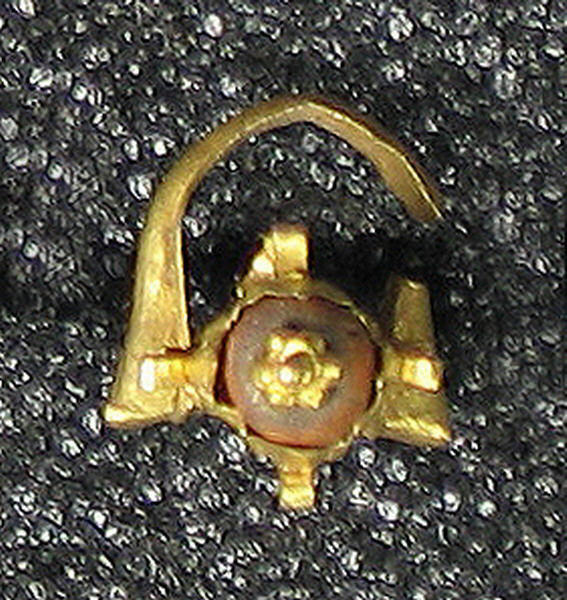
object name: earring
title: Cast Earring with Granulation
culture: indonesian, central java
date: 701-1200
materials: gold